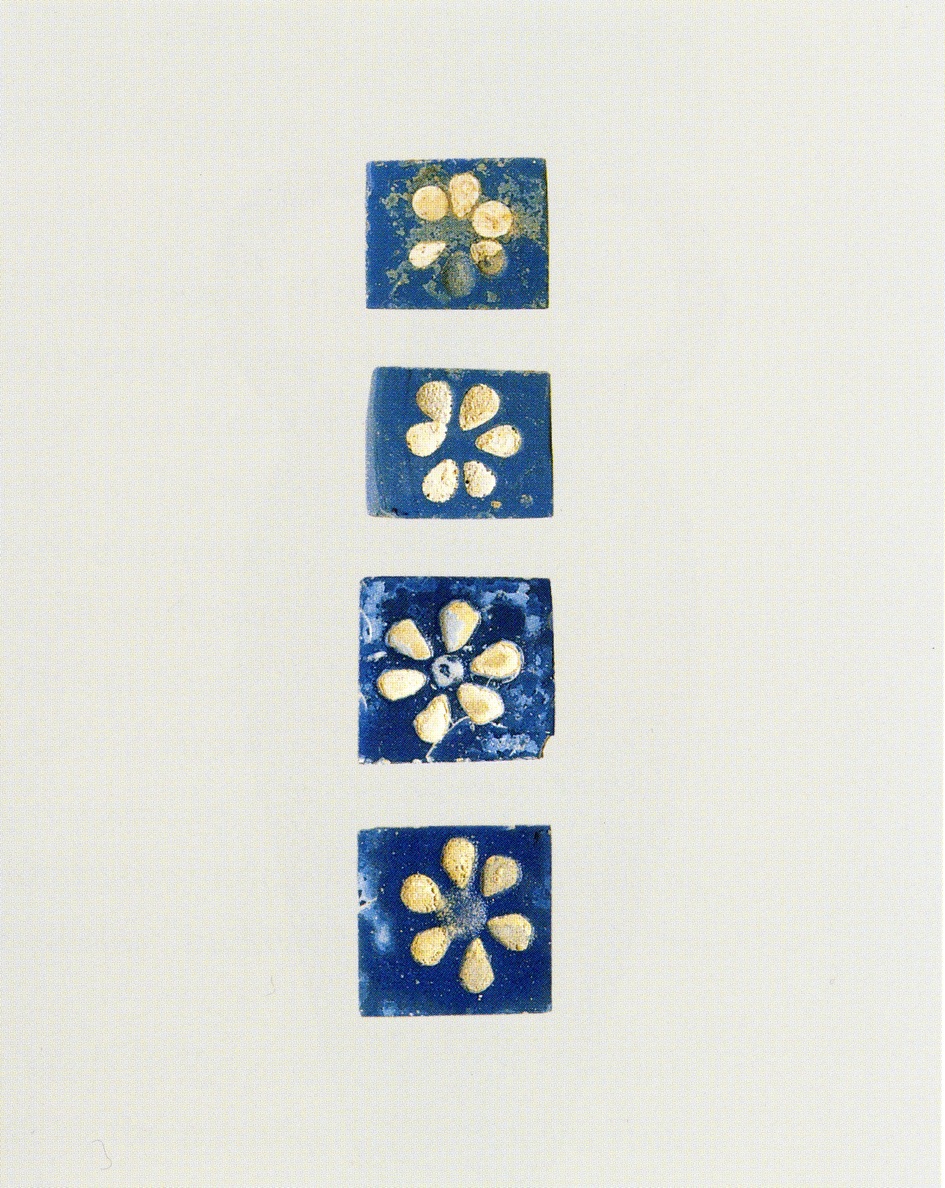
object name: inlay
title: Inlays: white rosettes on blue backgrounds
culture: assyrian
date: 900-701 BCE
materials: glass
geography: mesopotamia